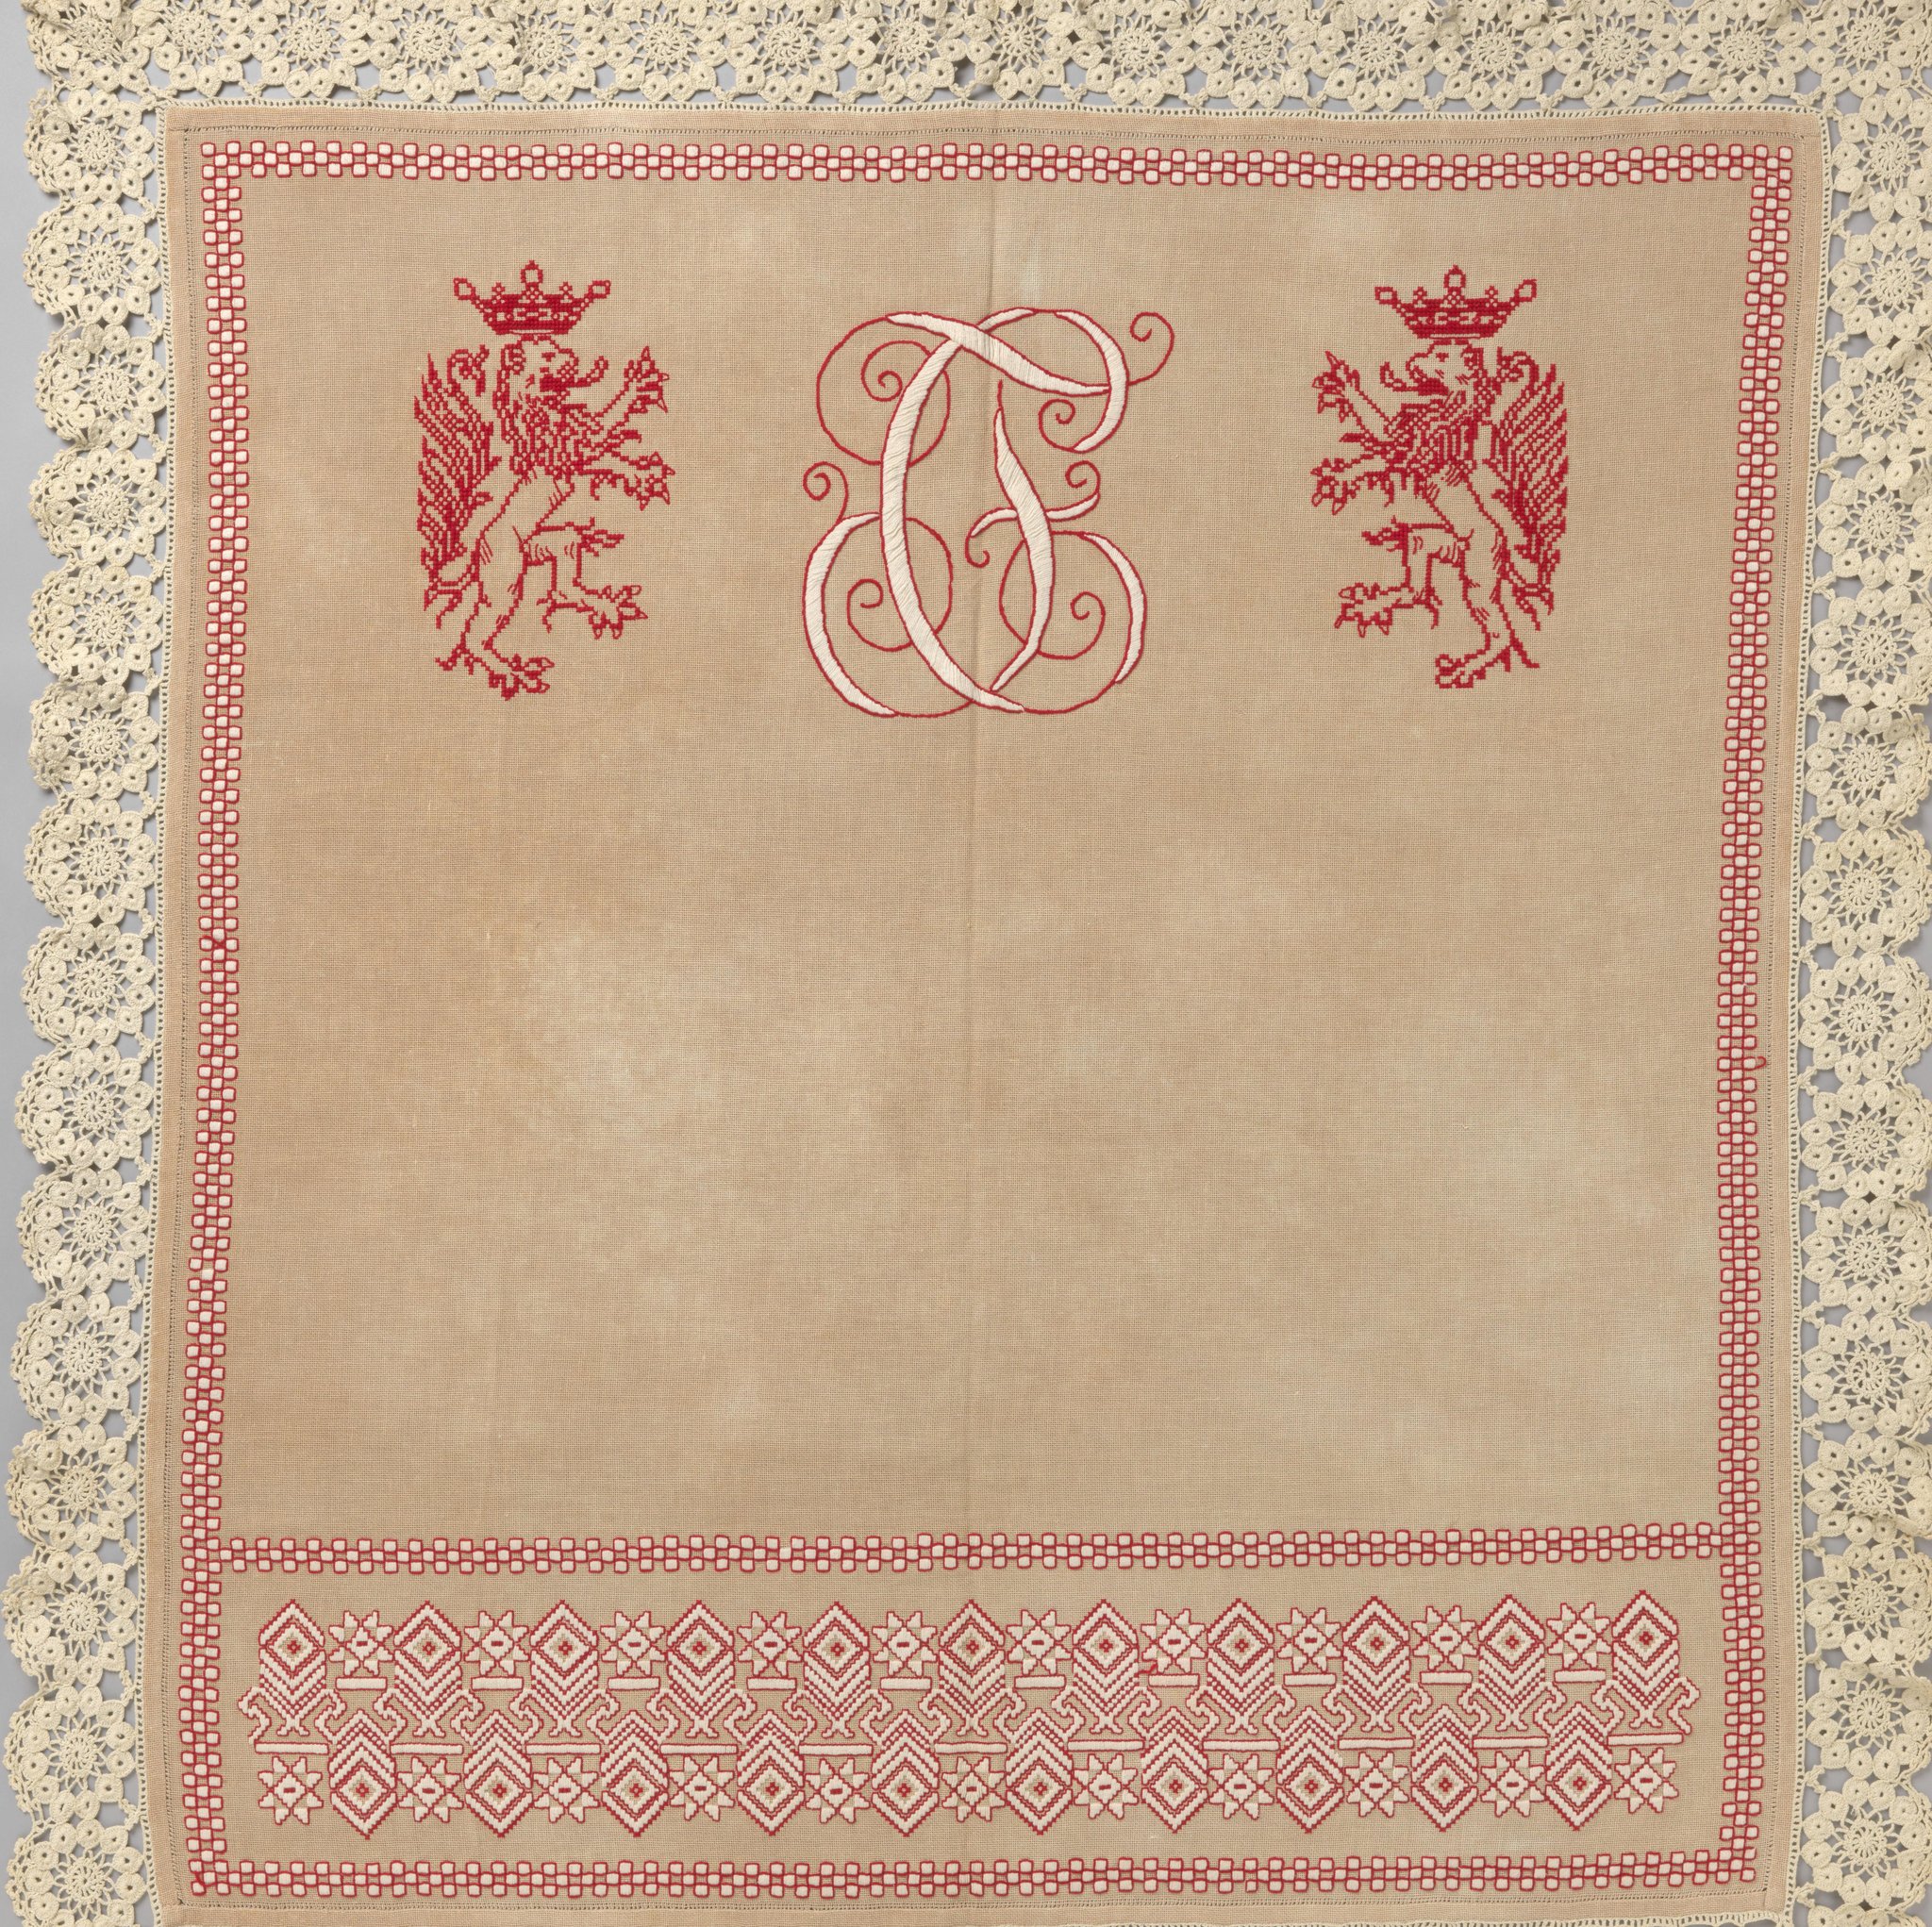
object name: bedspread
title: Sprei met in wit en rood geborduurd monogram met de letters CF of FC tussen twee gekroonde, klimmende leeuwen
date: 1870-1880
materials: cotton, yarns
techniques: embroidered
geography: netherlands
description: Sprei met borduurwerk in rood en wit. Patroon: in de onversierde bovenhelft staat bovenin een groot monogram in de schrijfletters CF of FC in wit met rode intrejm tussen twee gekroonde, klimmende leeuwen in rood. De benedenhelft toont drie geometrisch versierde banden, twee met meanderpatroon, één met blokjes, in wit met rode contour, onderbroken door twee entre-deux van rozetten in haakwerk. Rand met hetzelfde haakwerk.